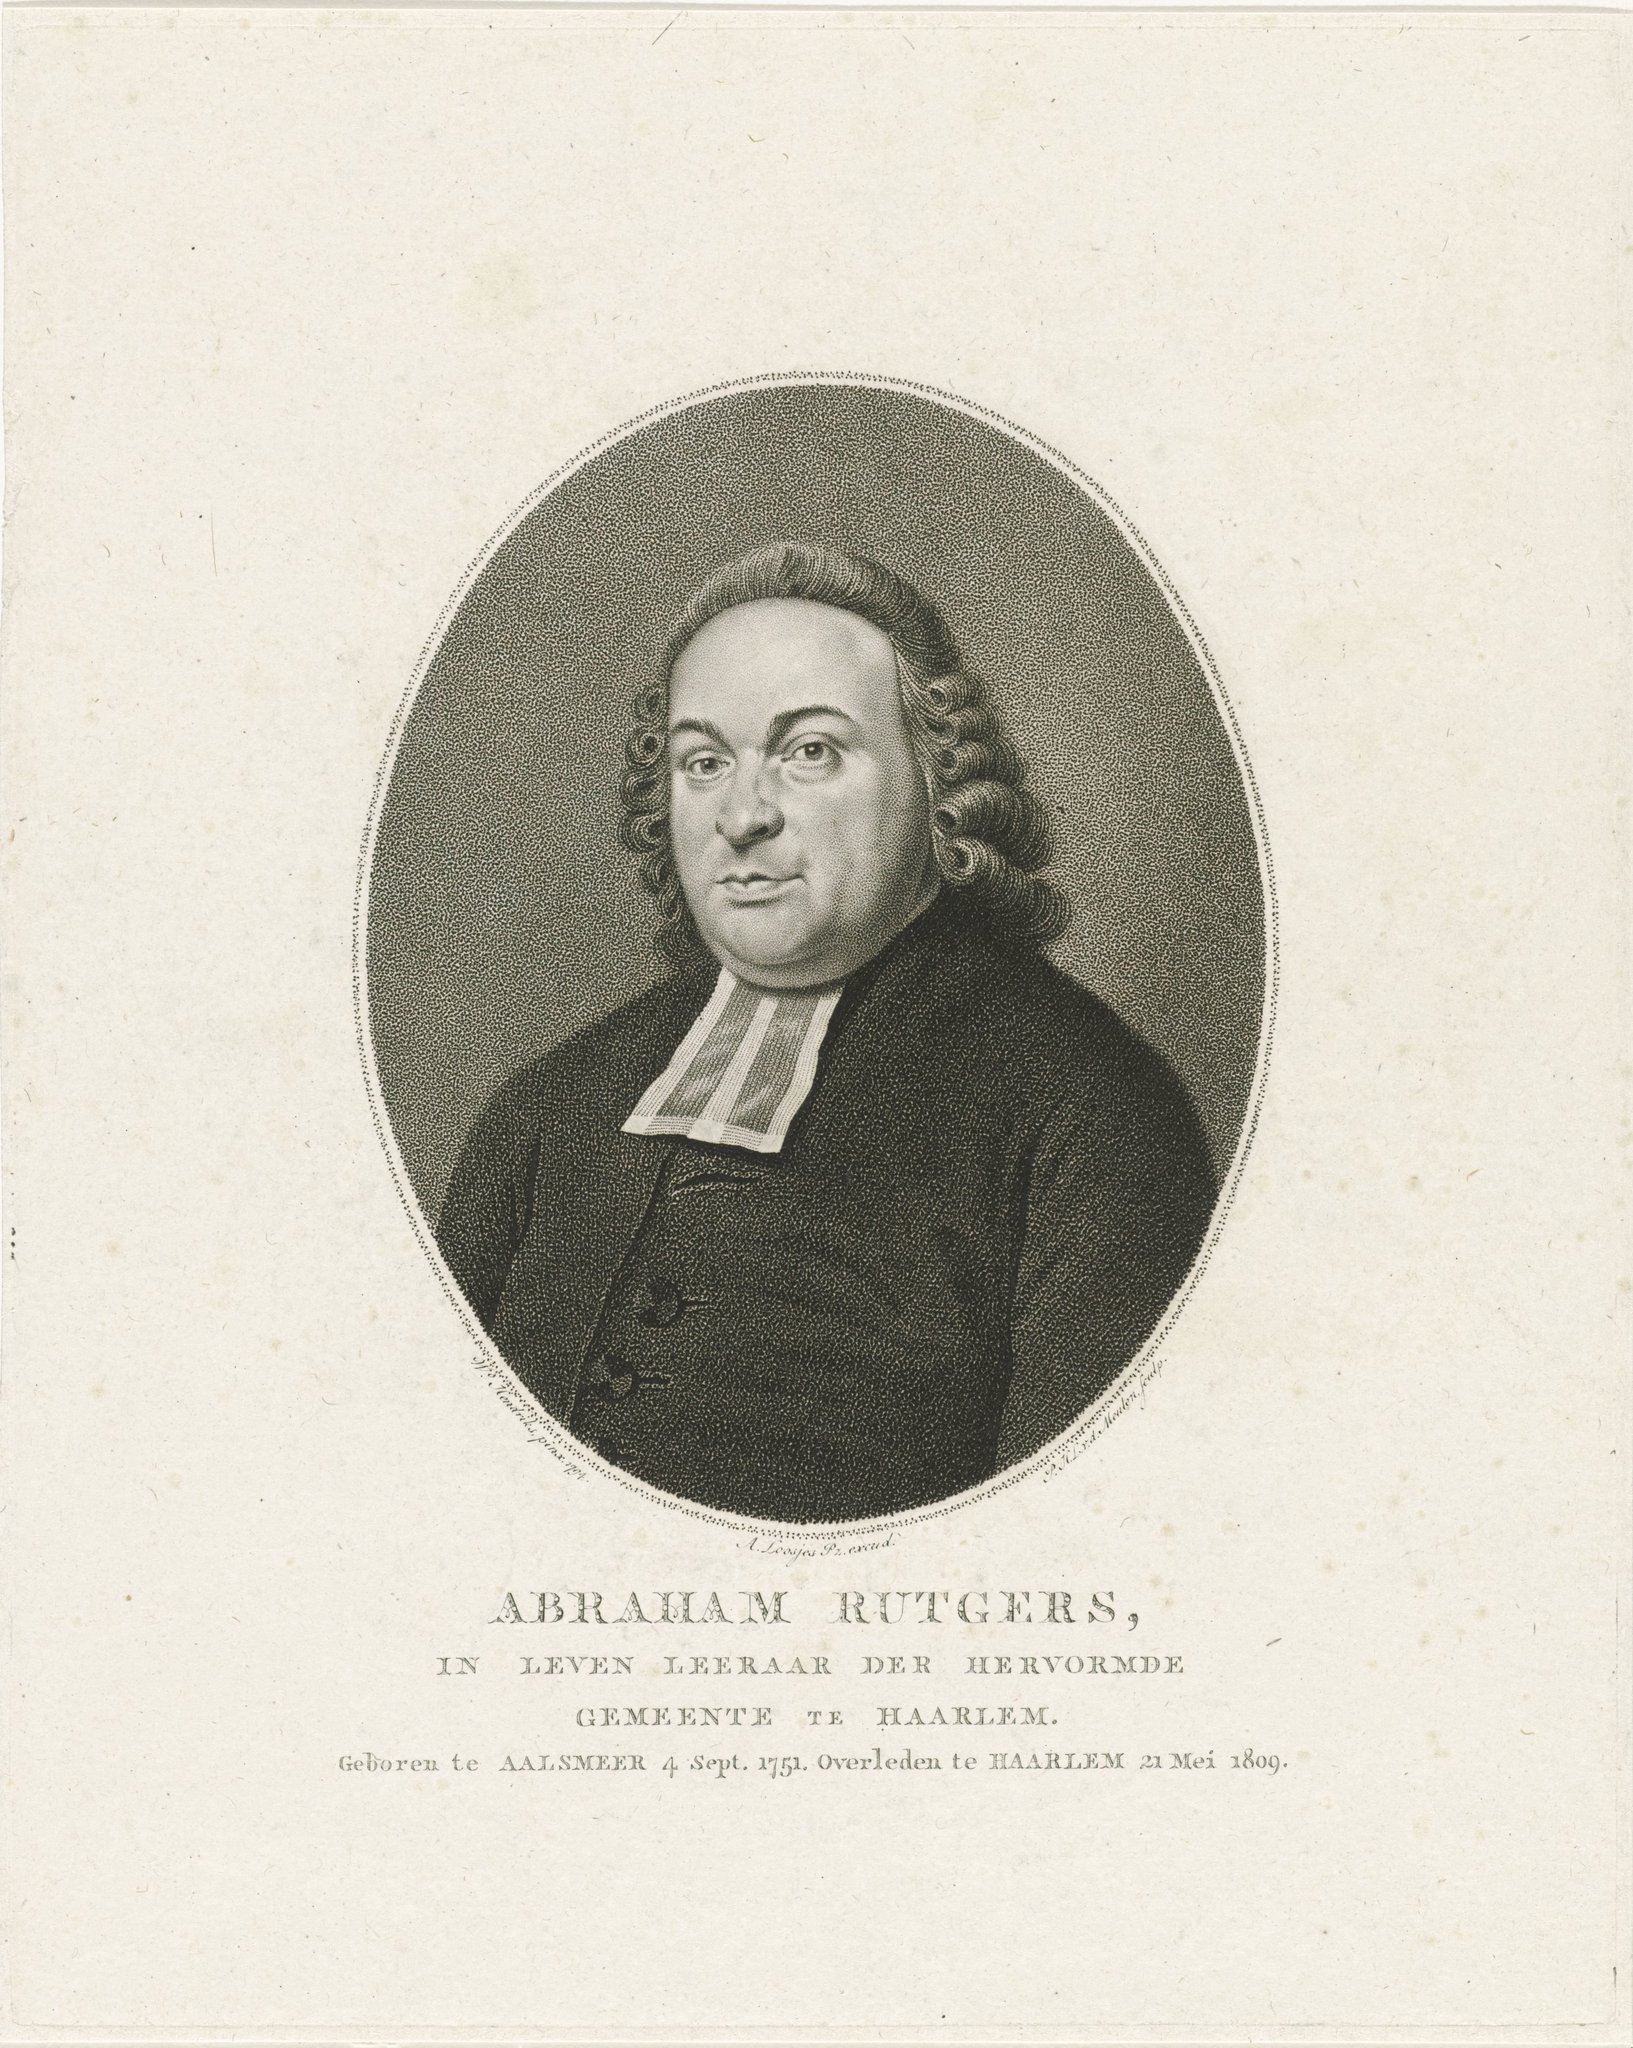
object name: print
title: Portret van Abraham Rutgers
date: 1809-1811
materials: paper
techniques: stippled etching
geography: amsterdam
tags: haarlem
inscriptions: collector's mark: Lugt 2233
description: Portret van Abraham Rutgers, predikant te Haarlem.